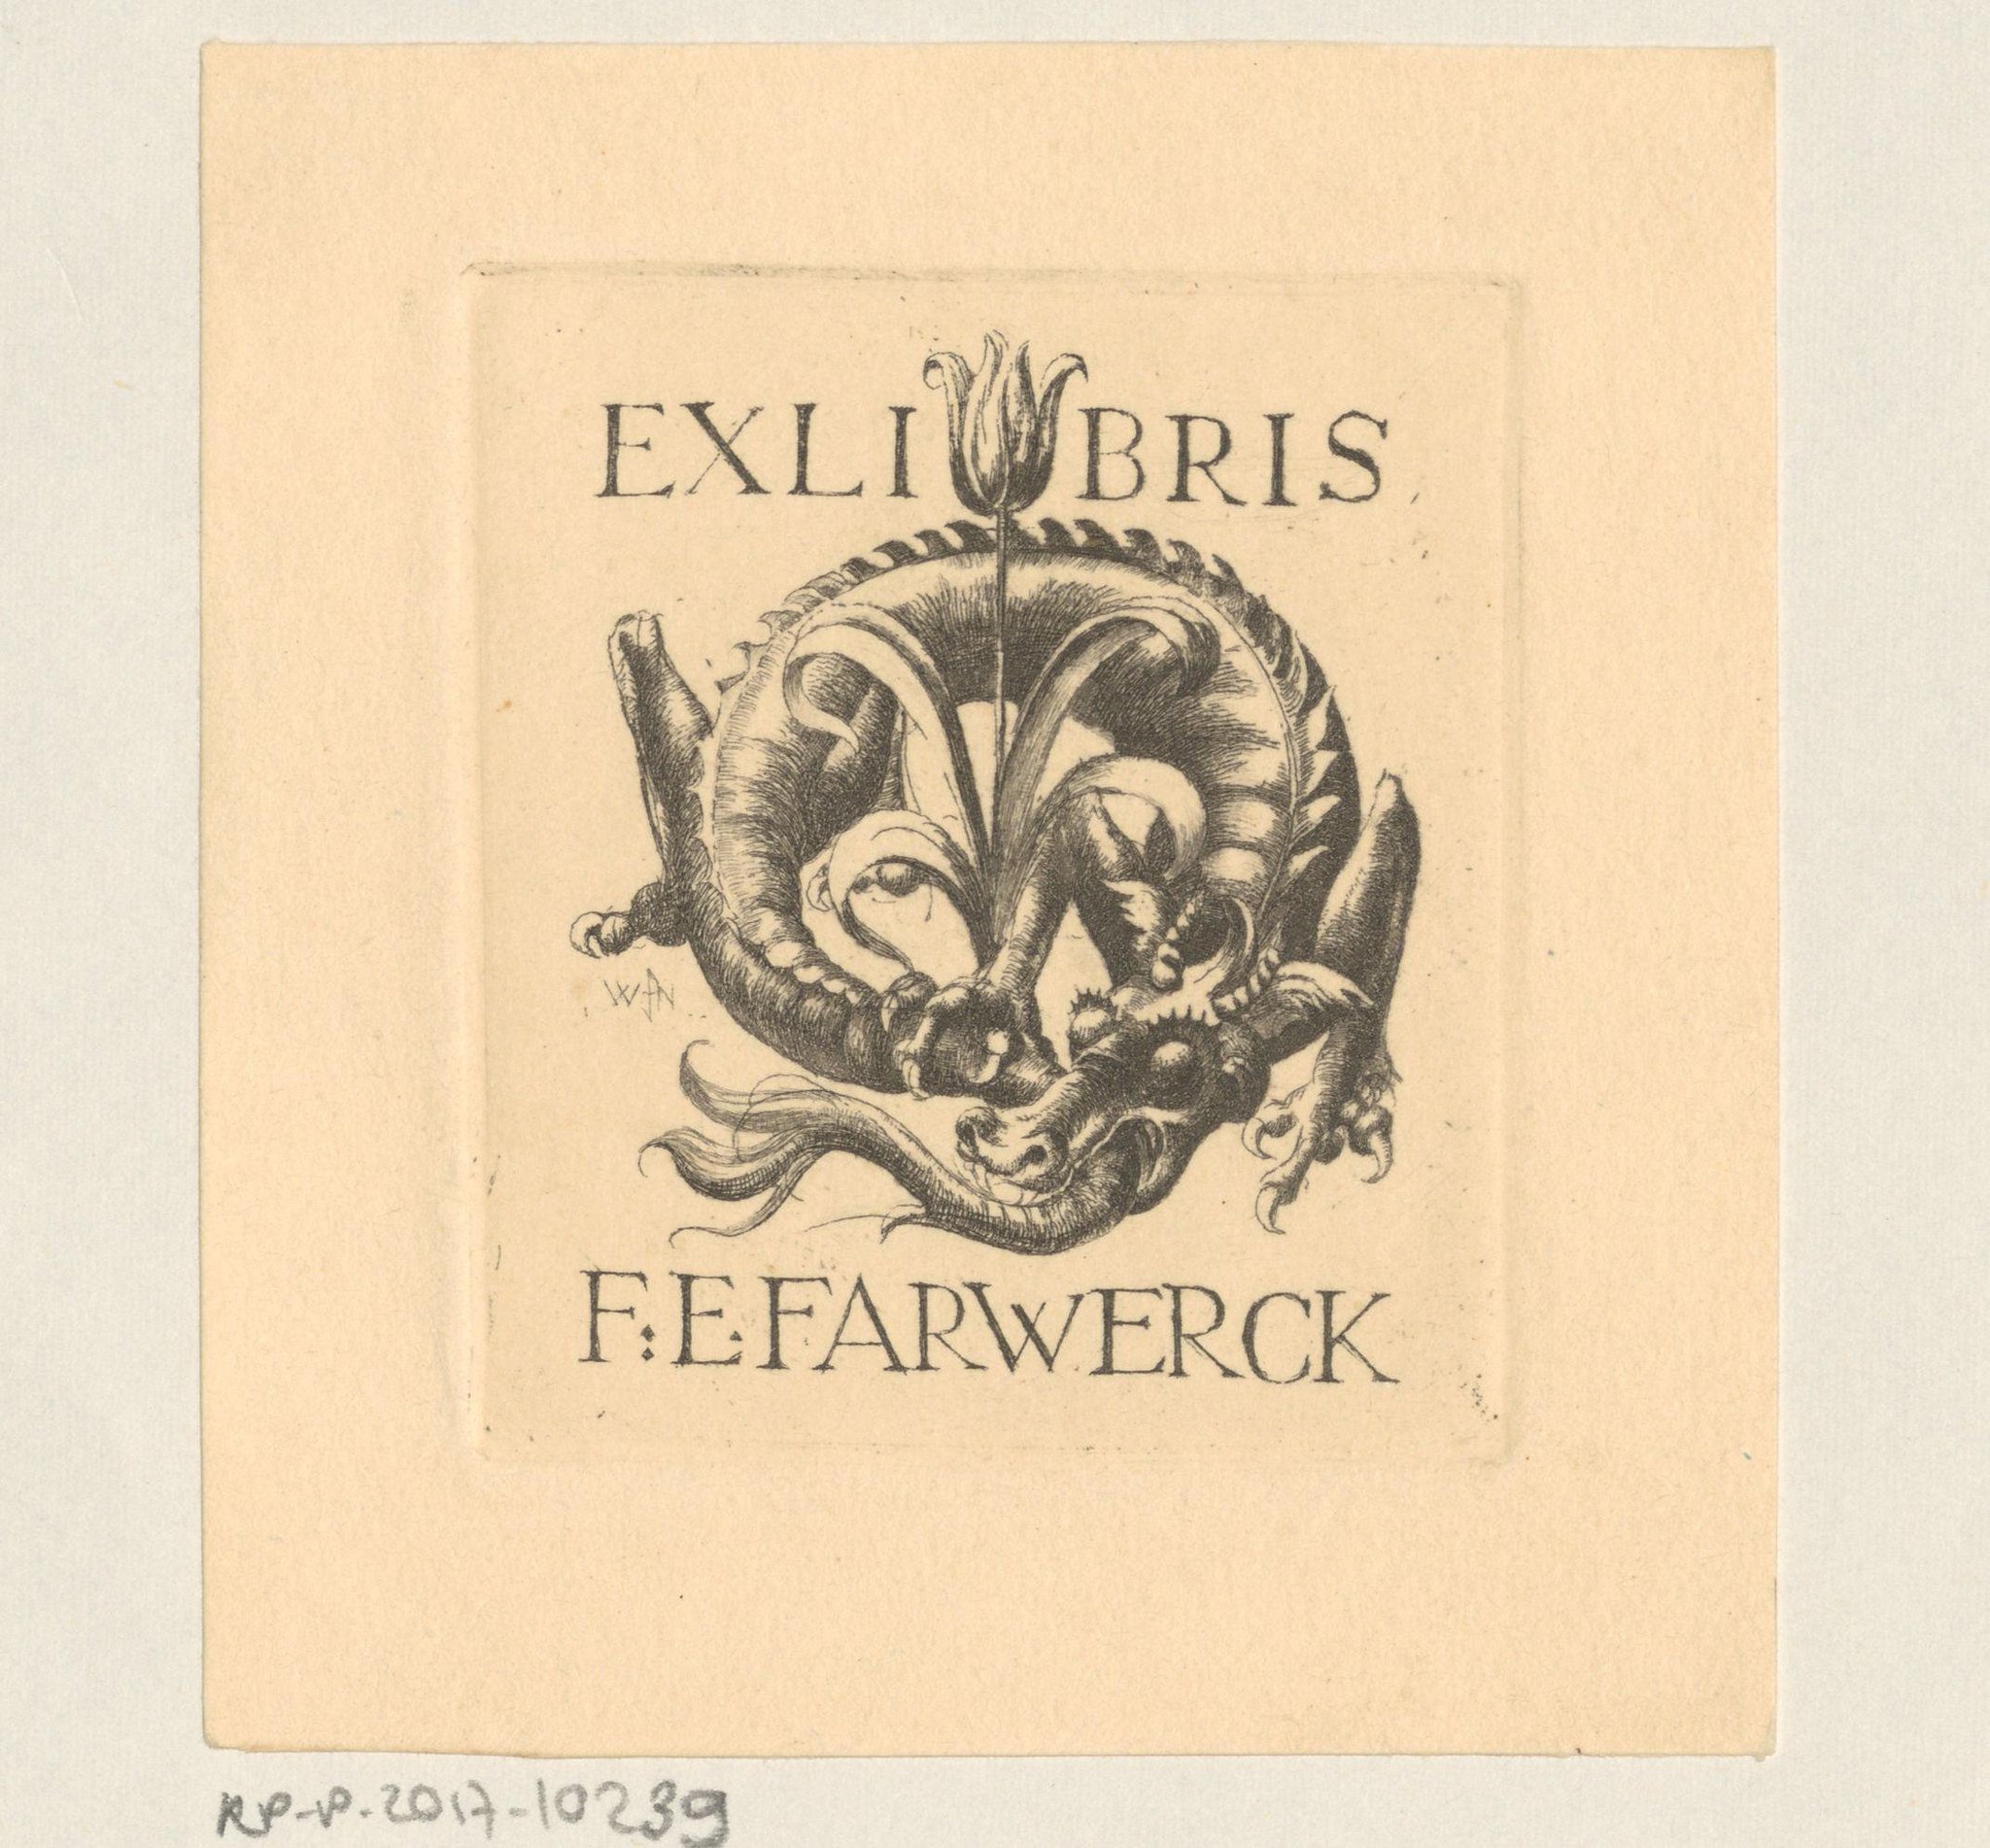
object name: bookplate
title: Ex libris van Frans Eduard Farwerck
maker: Anonymous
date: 1899-1969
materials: paper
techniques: etching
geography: netherlands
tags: dragon, flowers: tulip